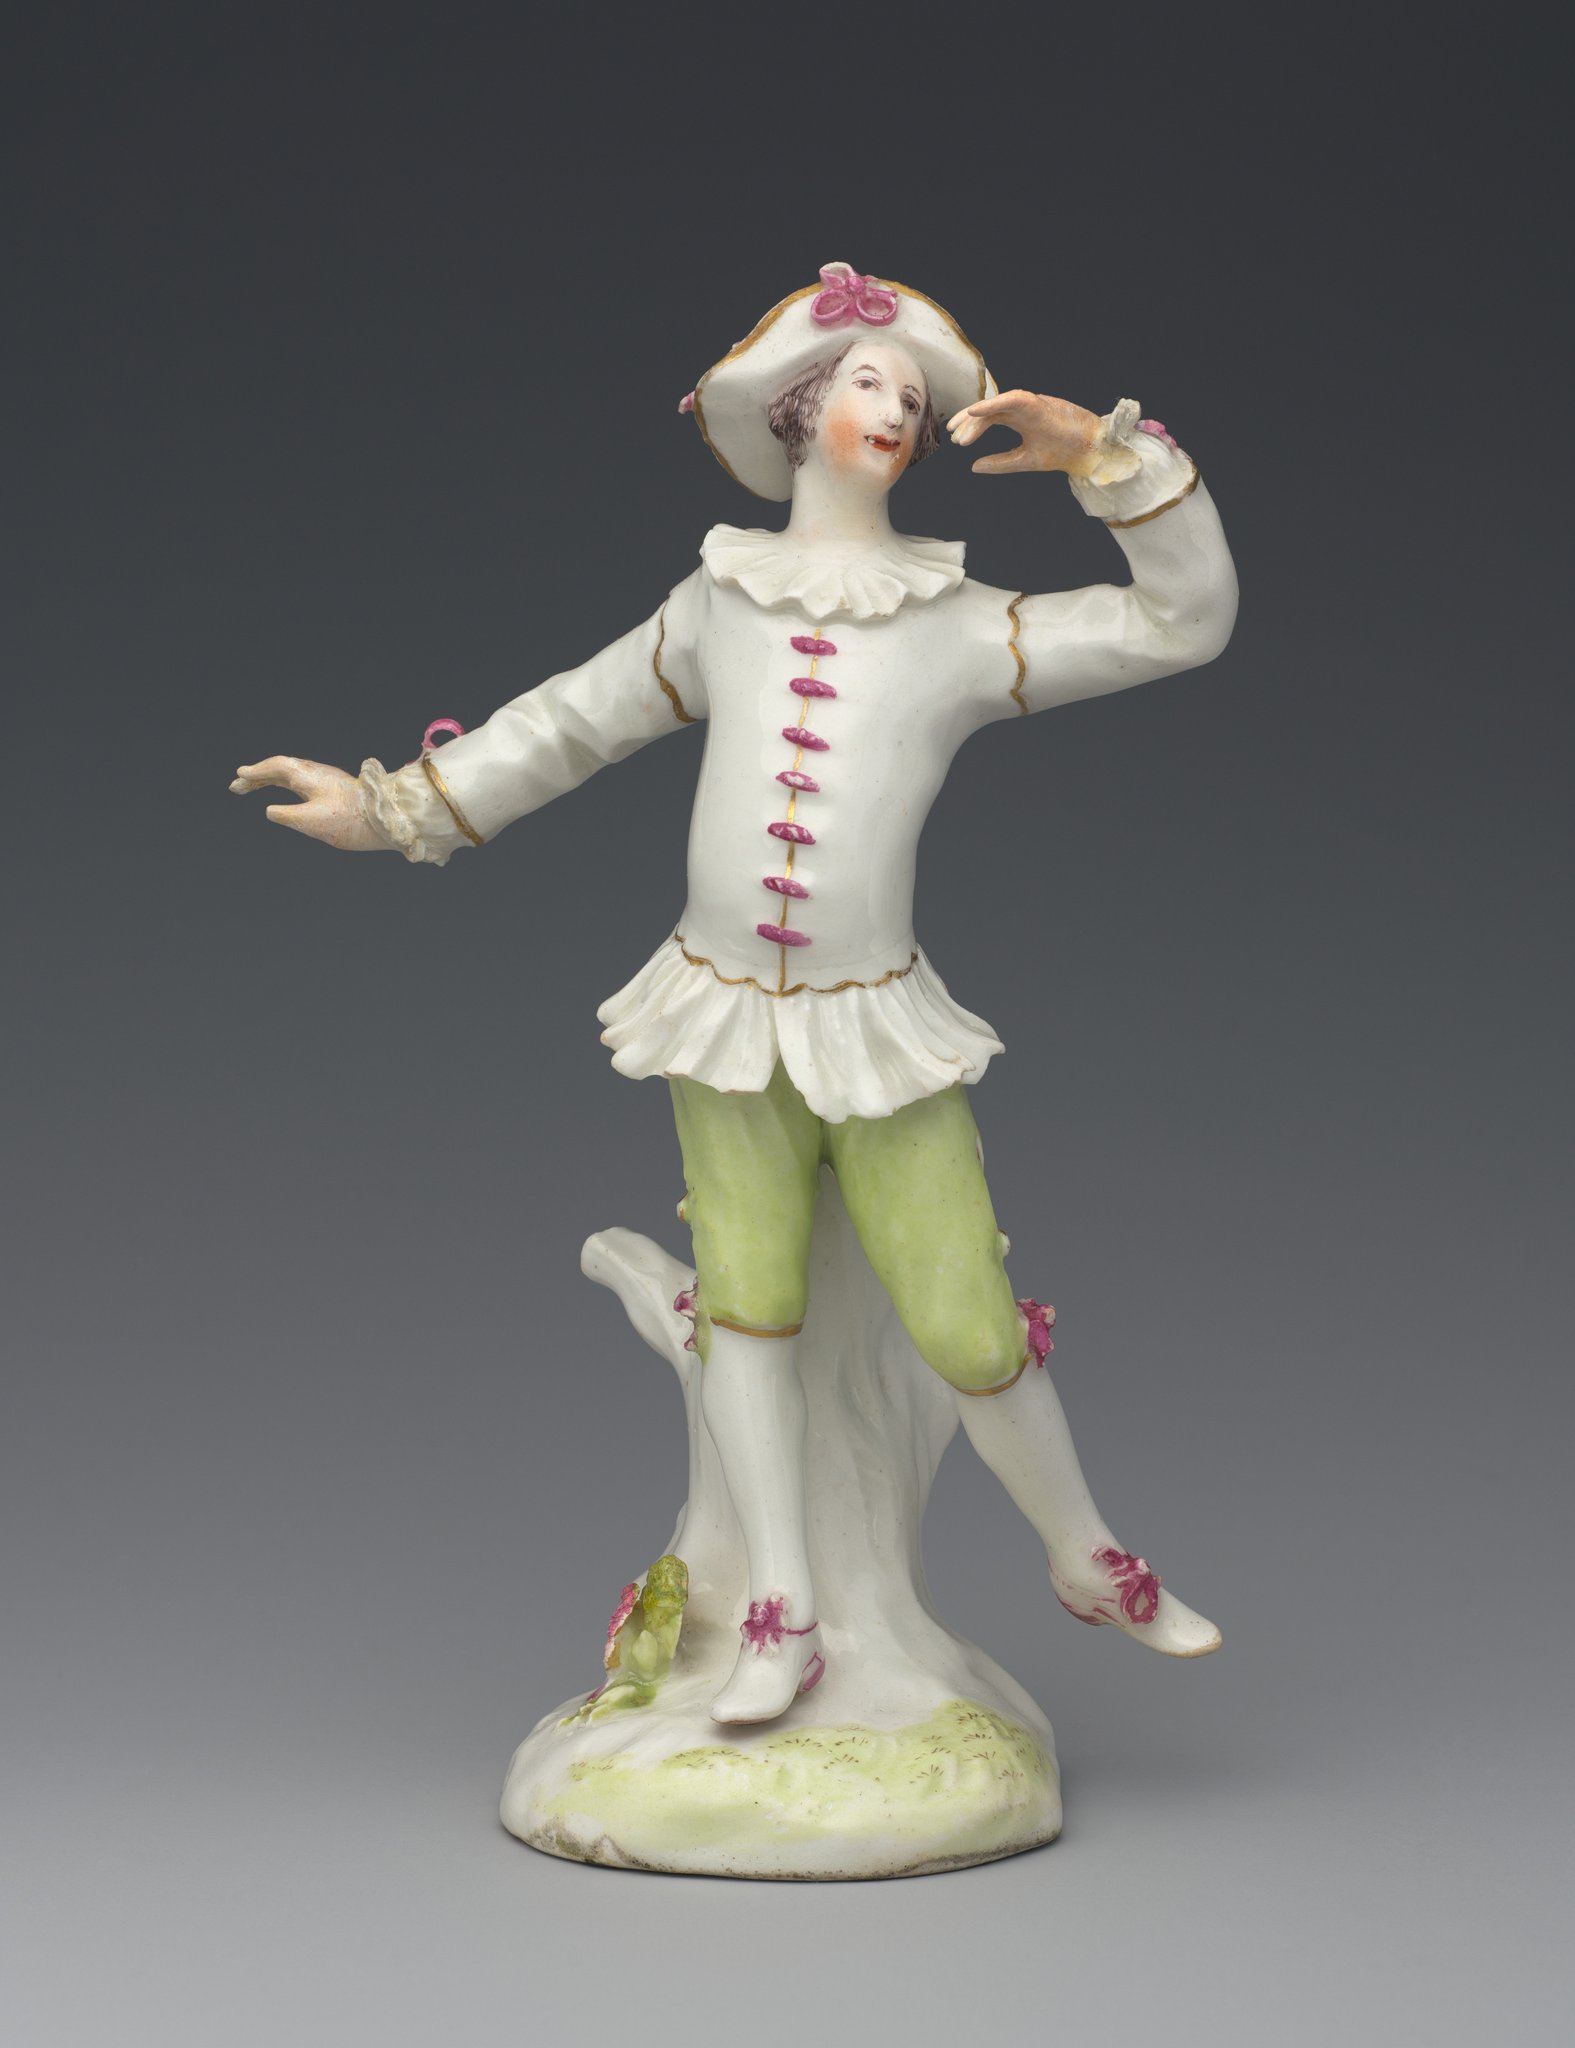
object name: figure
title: Dancer (one of a pair)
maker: derby porcelain manufactory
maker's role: factory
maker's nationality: british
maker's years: 1751-1785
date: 1755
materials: soft paste porcelain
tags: men,women,violins,dancers